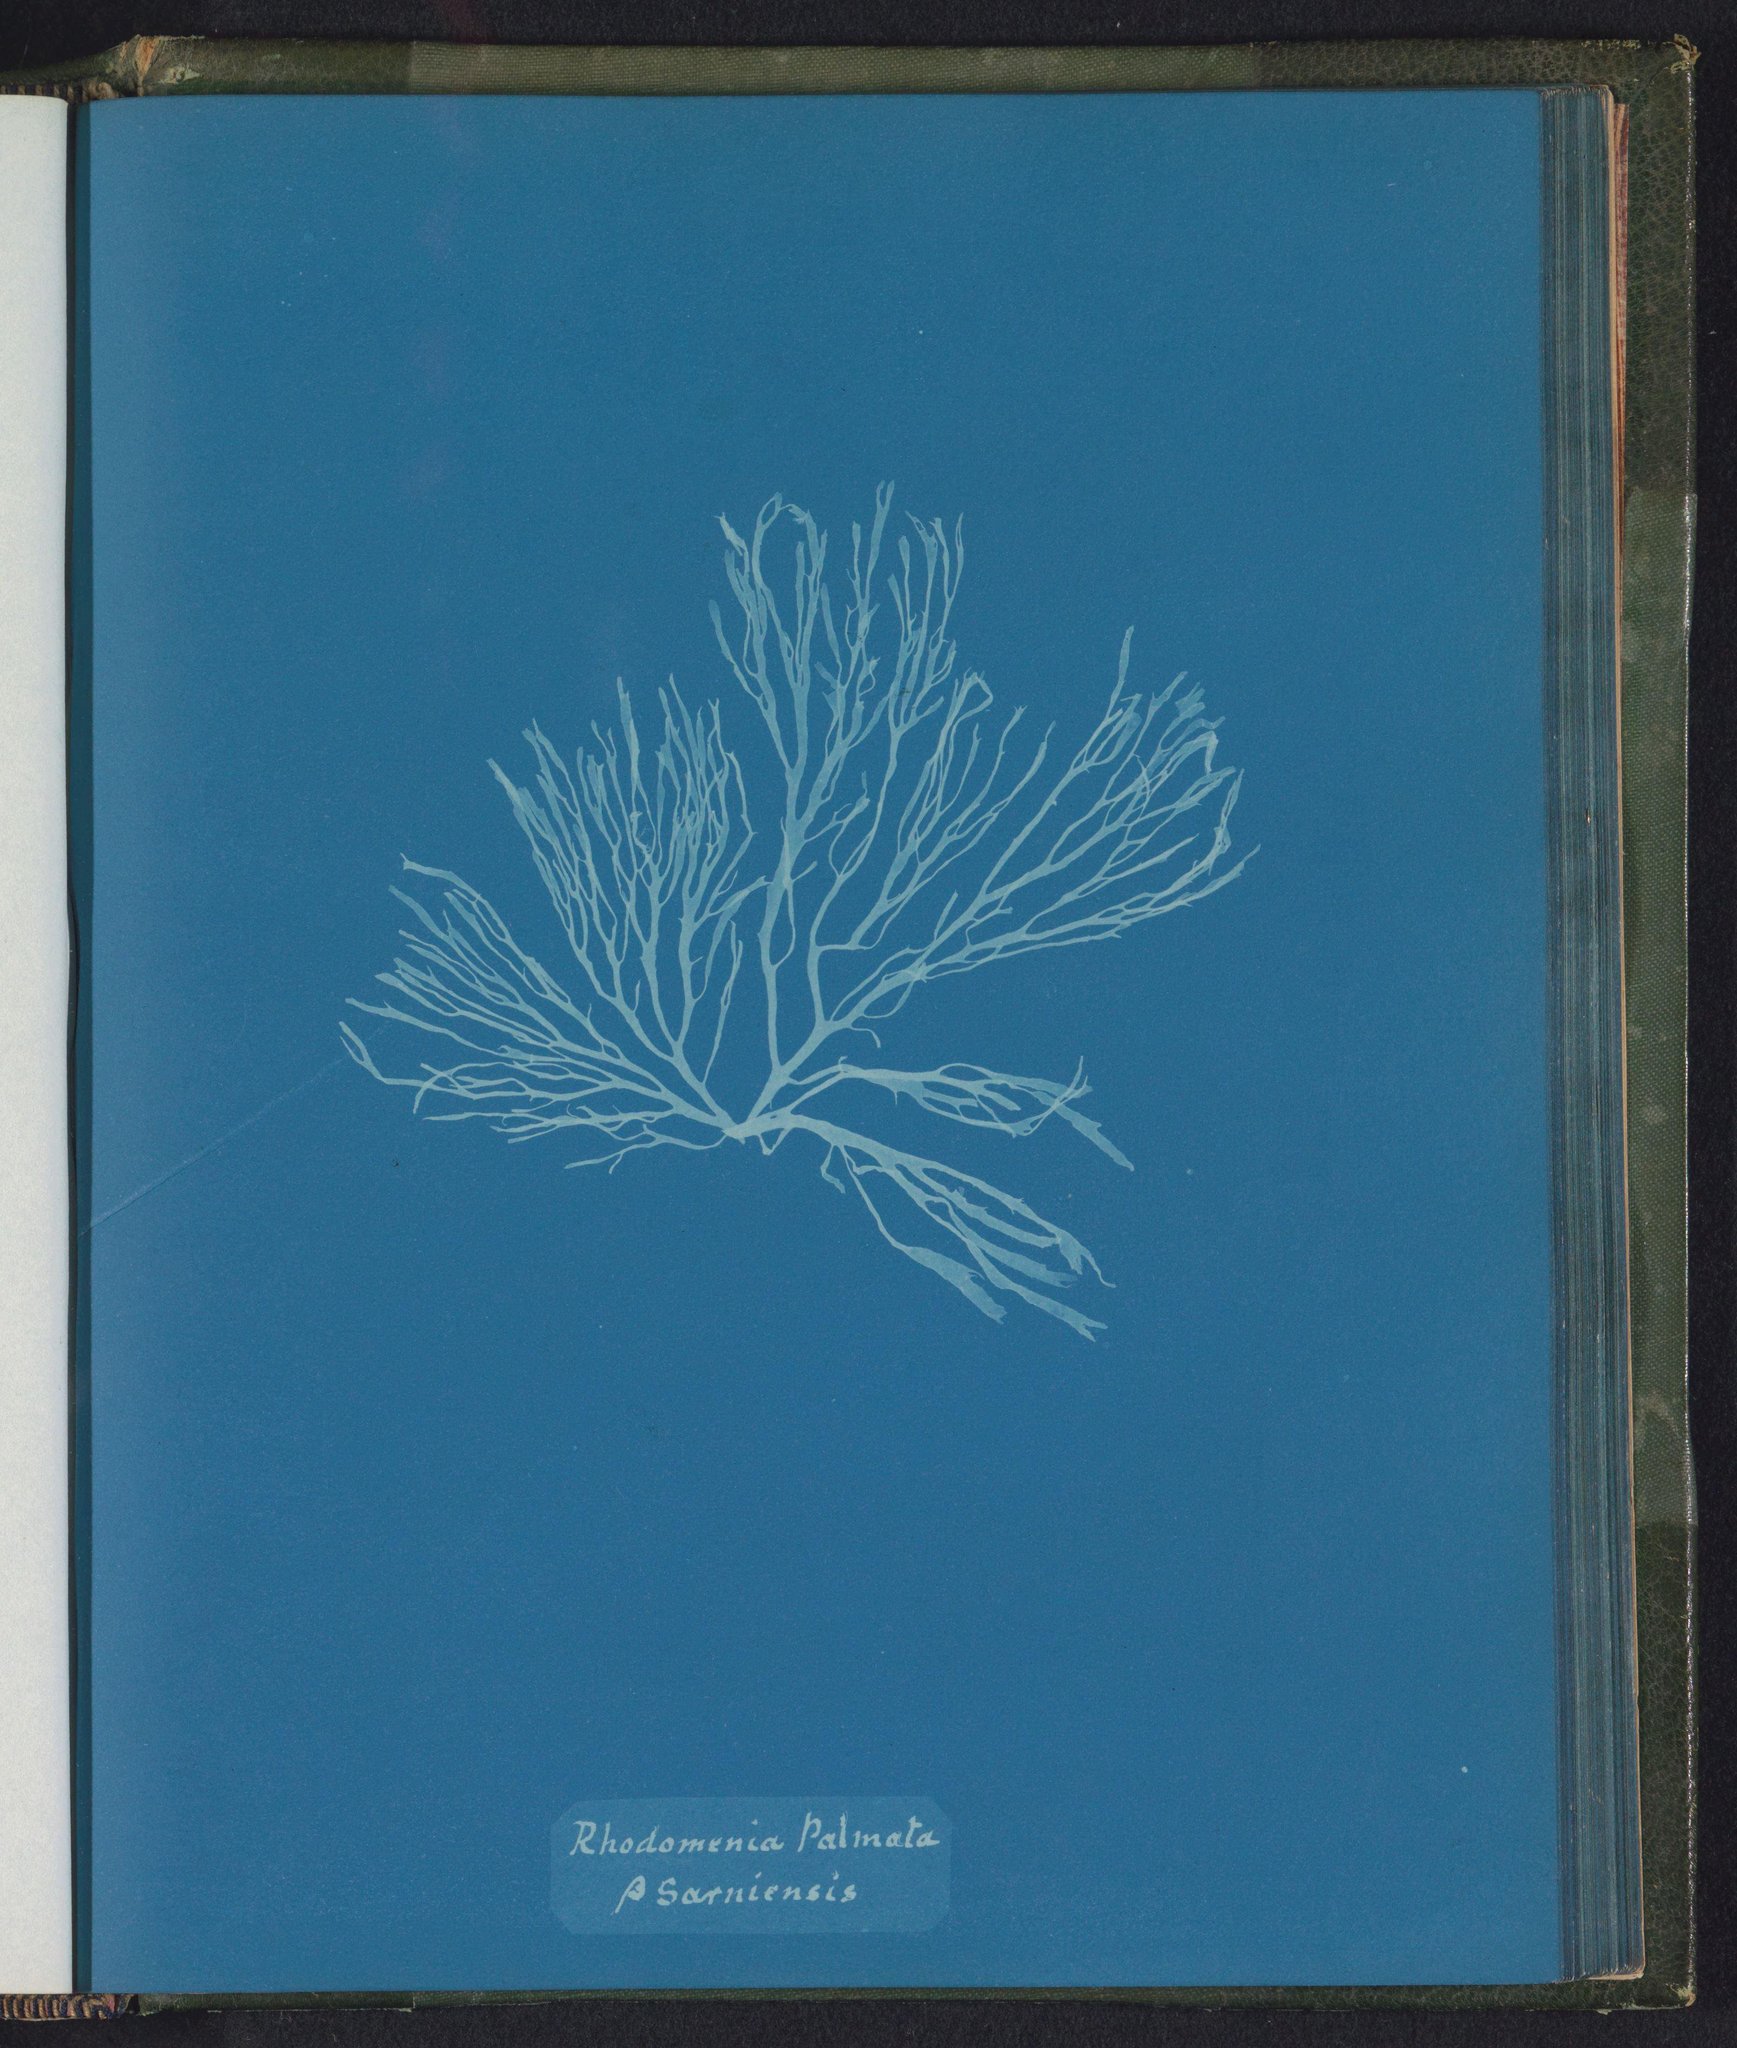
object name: page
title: Zeewier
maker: anna atkins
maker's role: fotograaf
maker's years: 1799-1871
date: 1843-1853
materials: photographic support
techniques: cyanotype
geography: united kingdom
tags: algae, seaweed